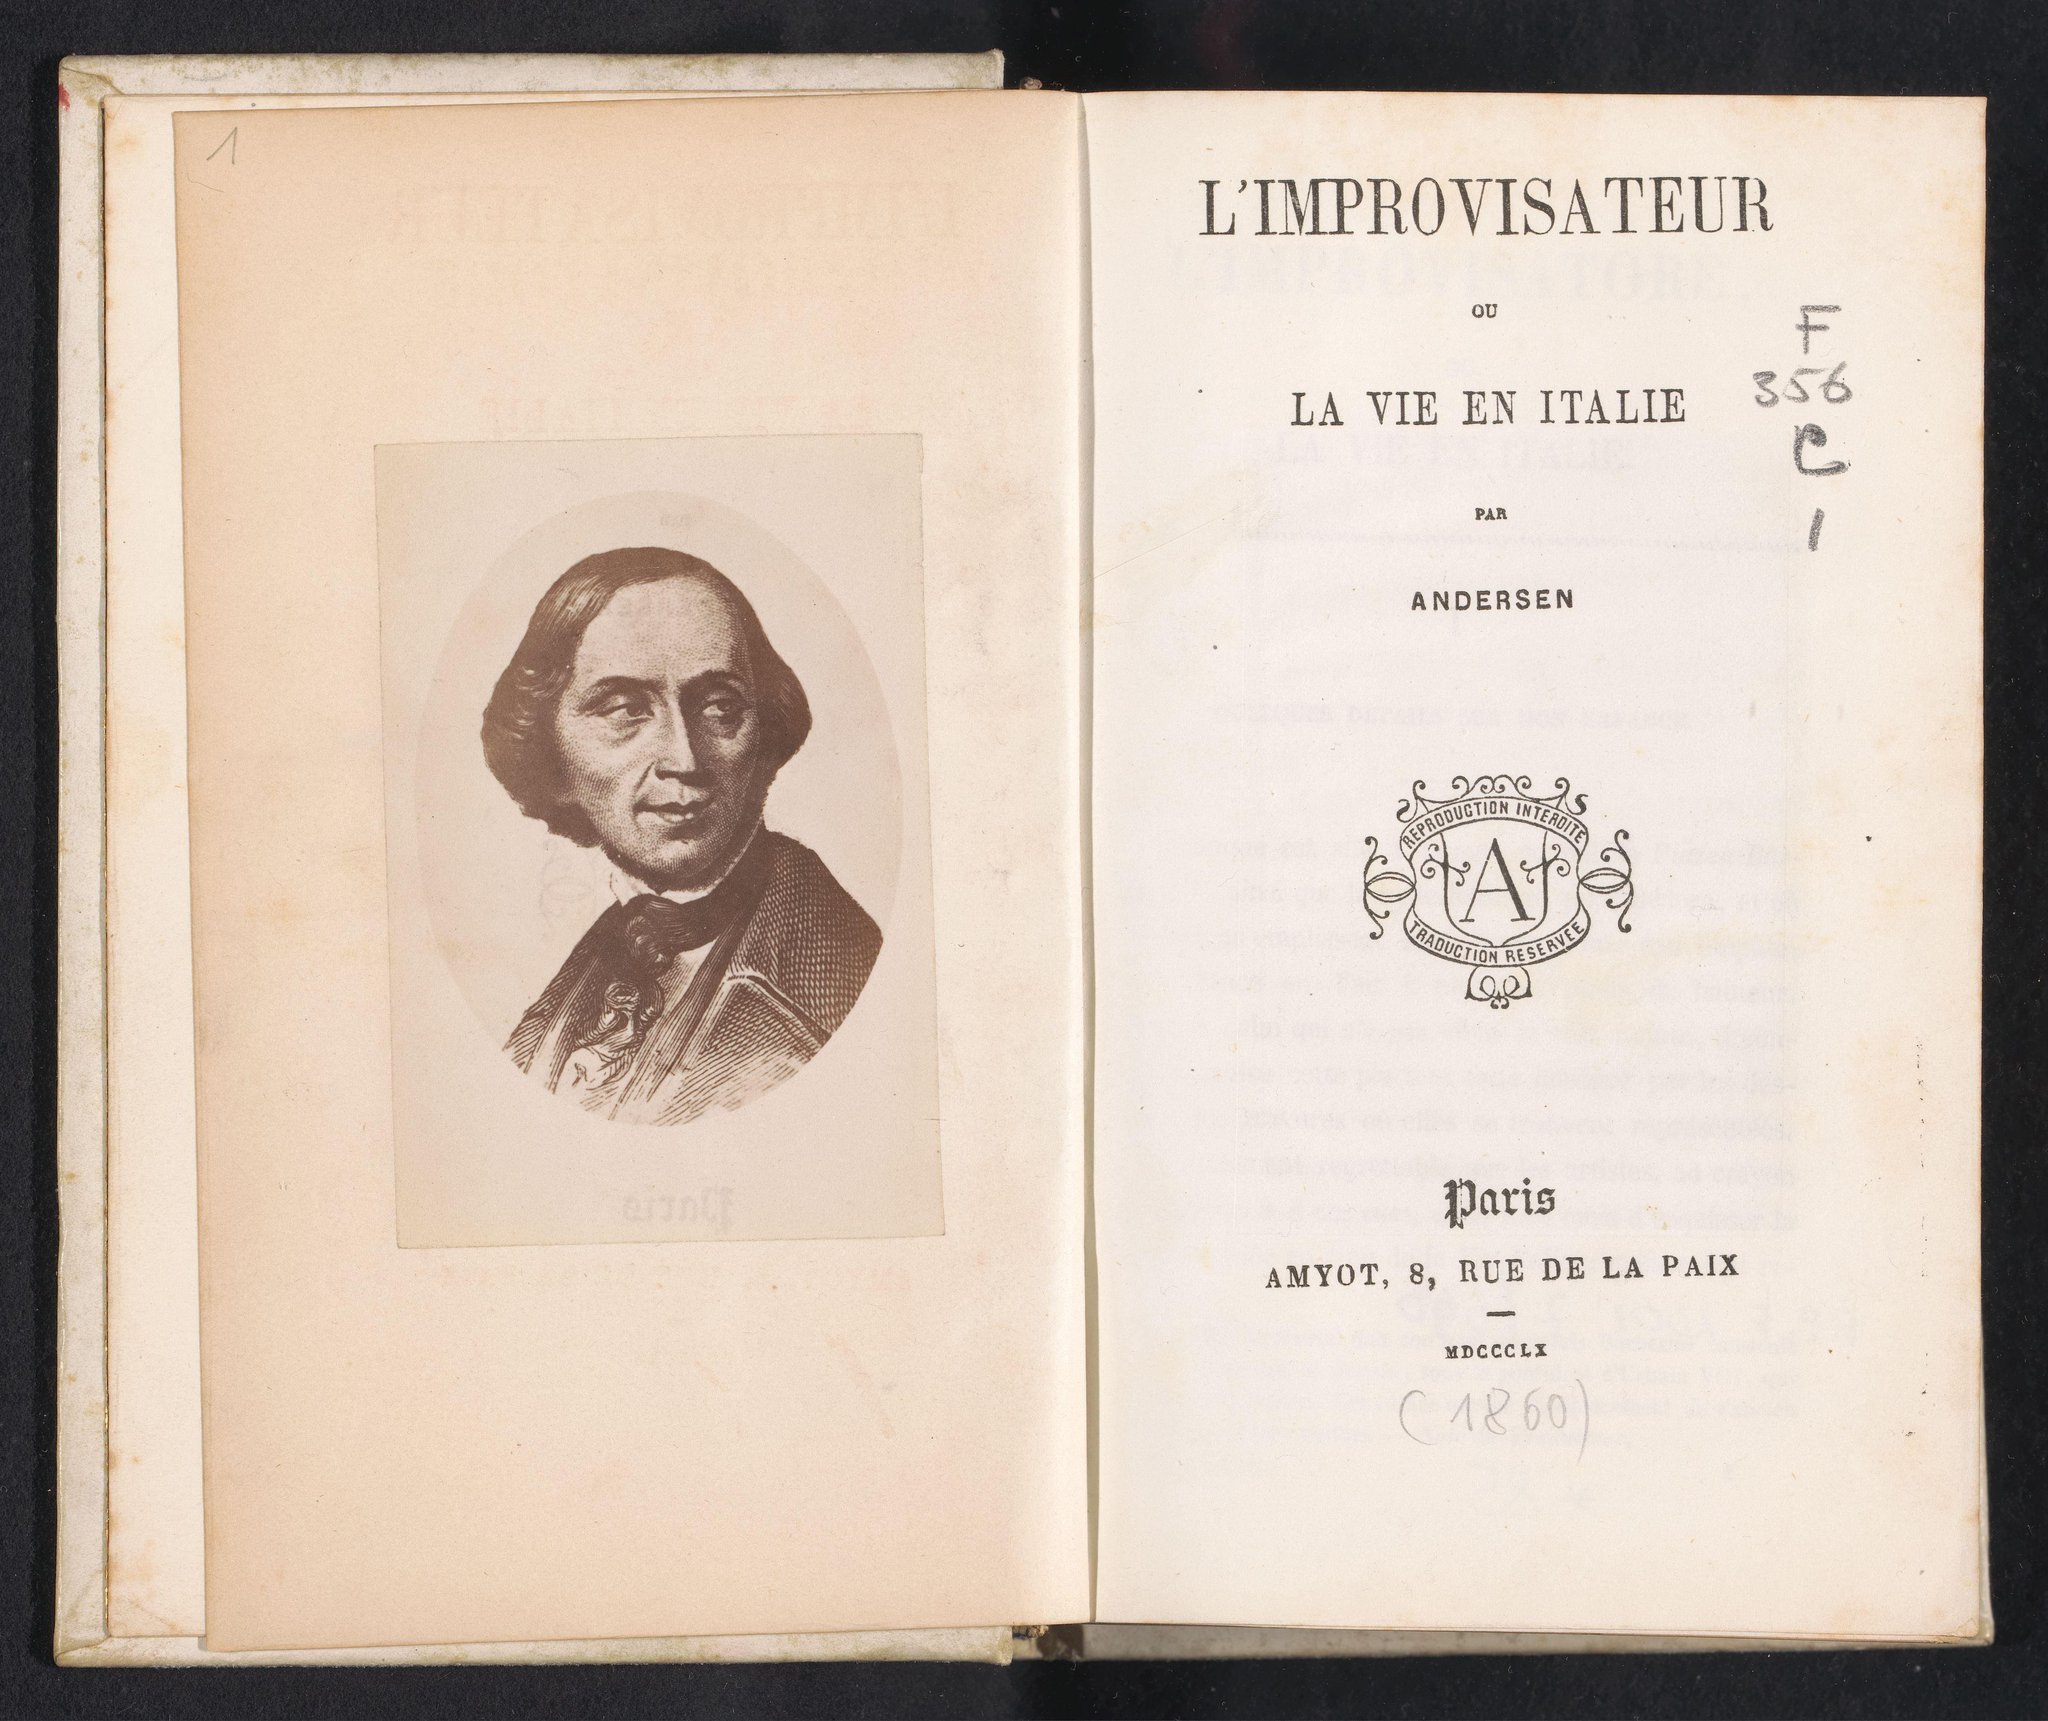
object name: book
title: L'improvisateur ou la vie en Italie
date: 1860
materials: cardboard, paper, photographic support, parchment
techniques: albumen print, marbled paper, printing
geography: paris